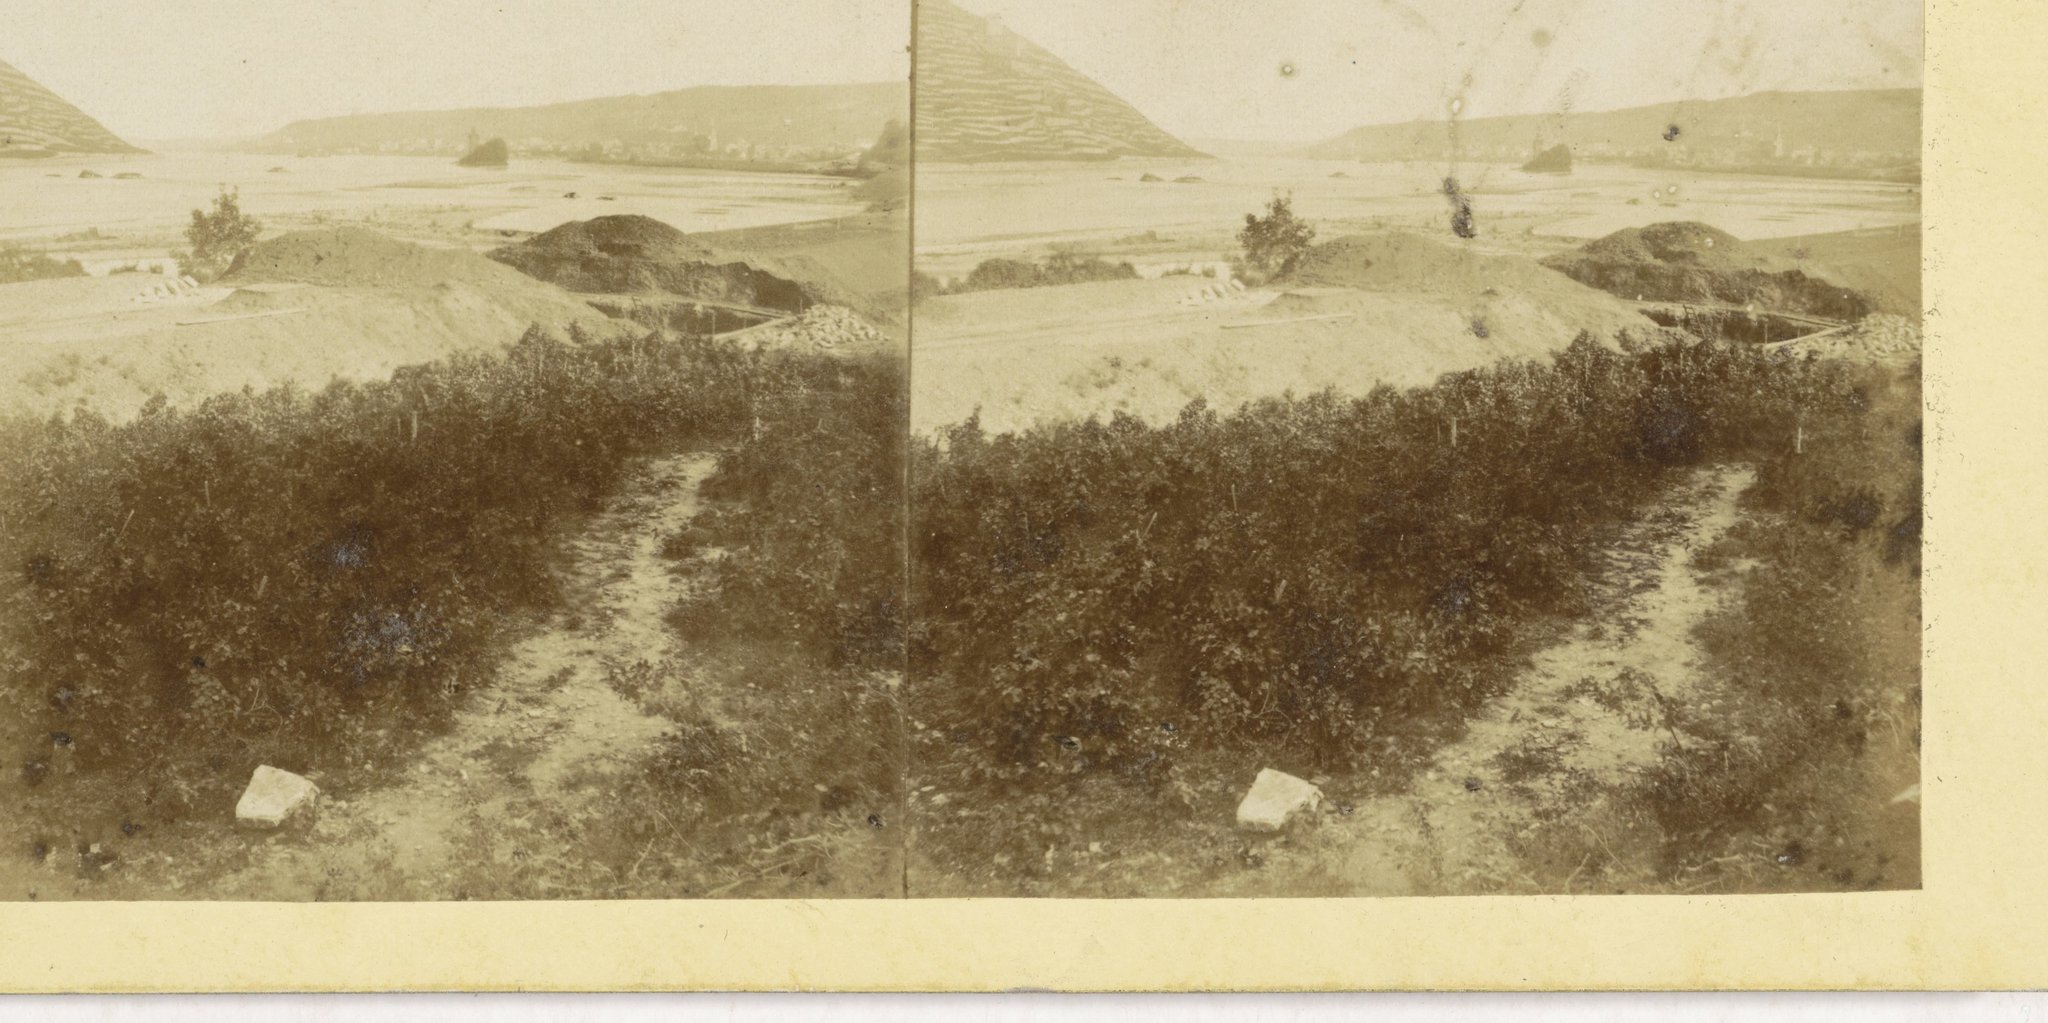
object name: stereograph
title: Panorama de Bingen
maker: Anonymous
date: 1861-1870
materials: cardboard, paper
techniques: albumen print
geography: bingen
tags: river bank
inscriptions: number: ‘No 95’, inscription: ‘6’